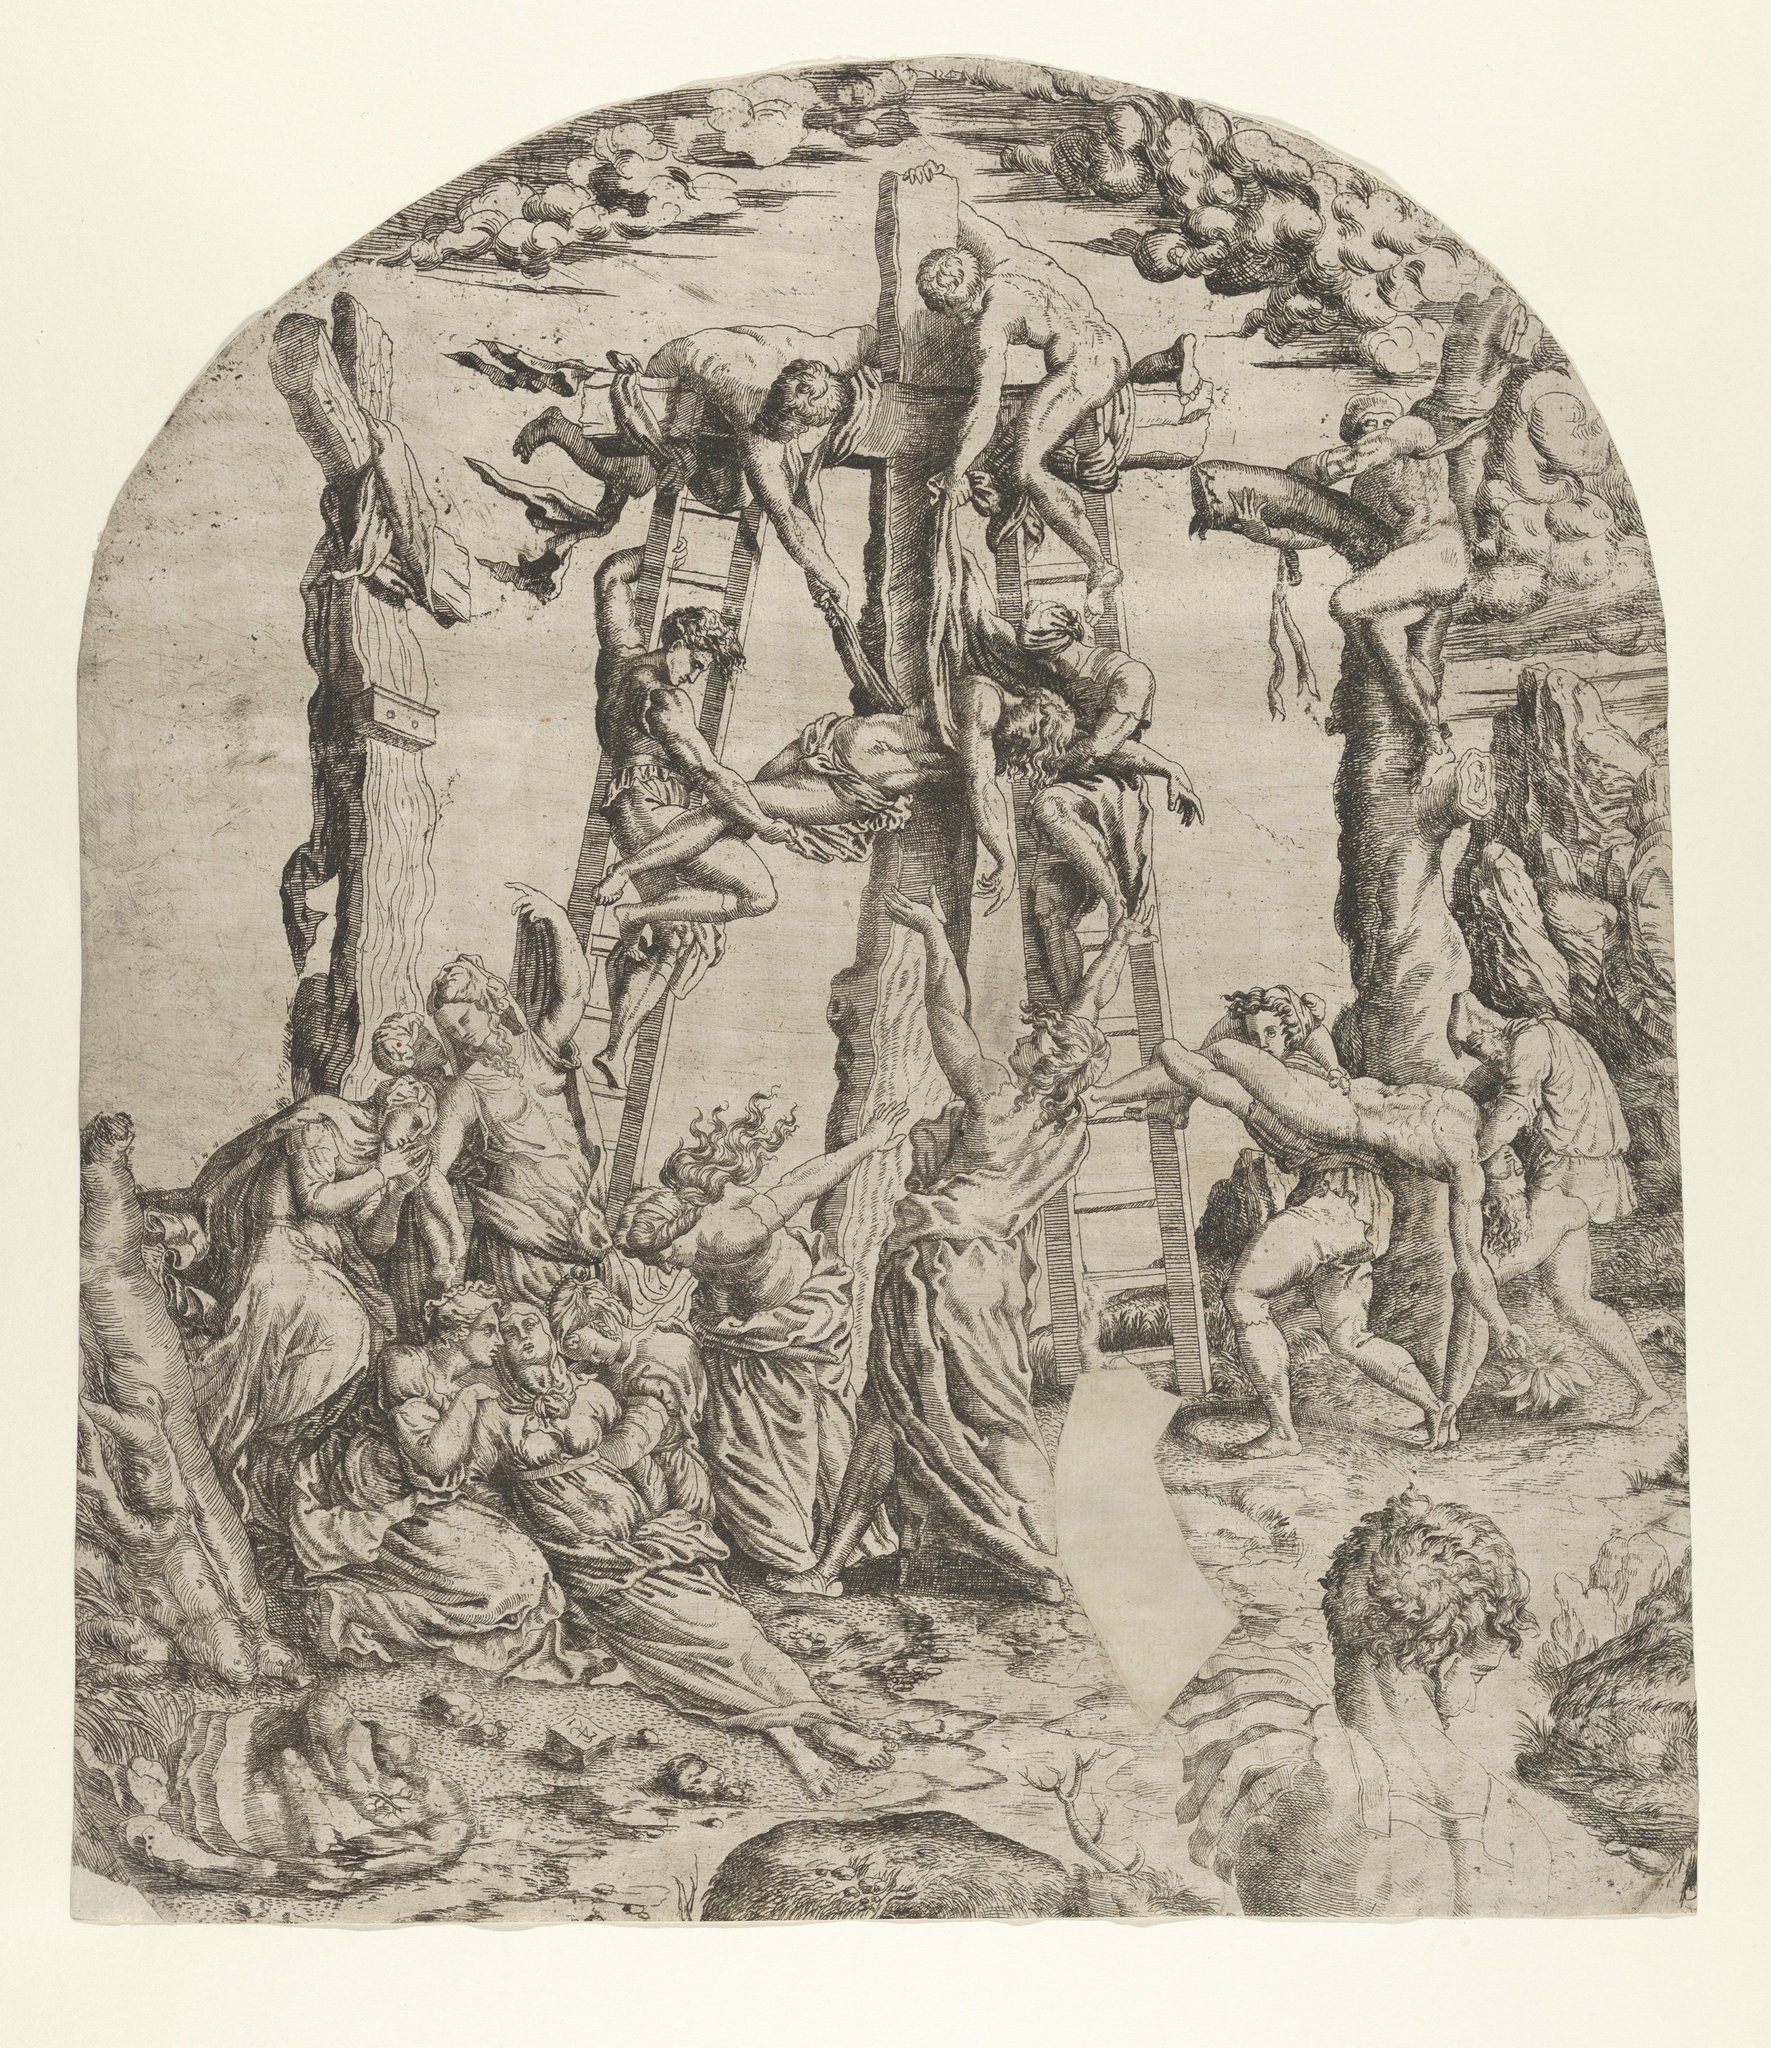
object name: print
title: Descent from the Cross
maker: master iqv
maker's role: artist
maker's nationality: french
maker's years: 1500-1600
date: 1543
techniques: etching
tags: men,women,christ,descent from the cross